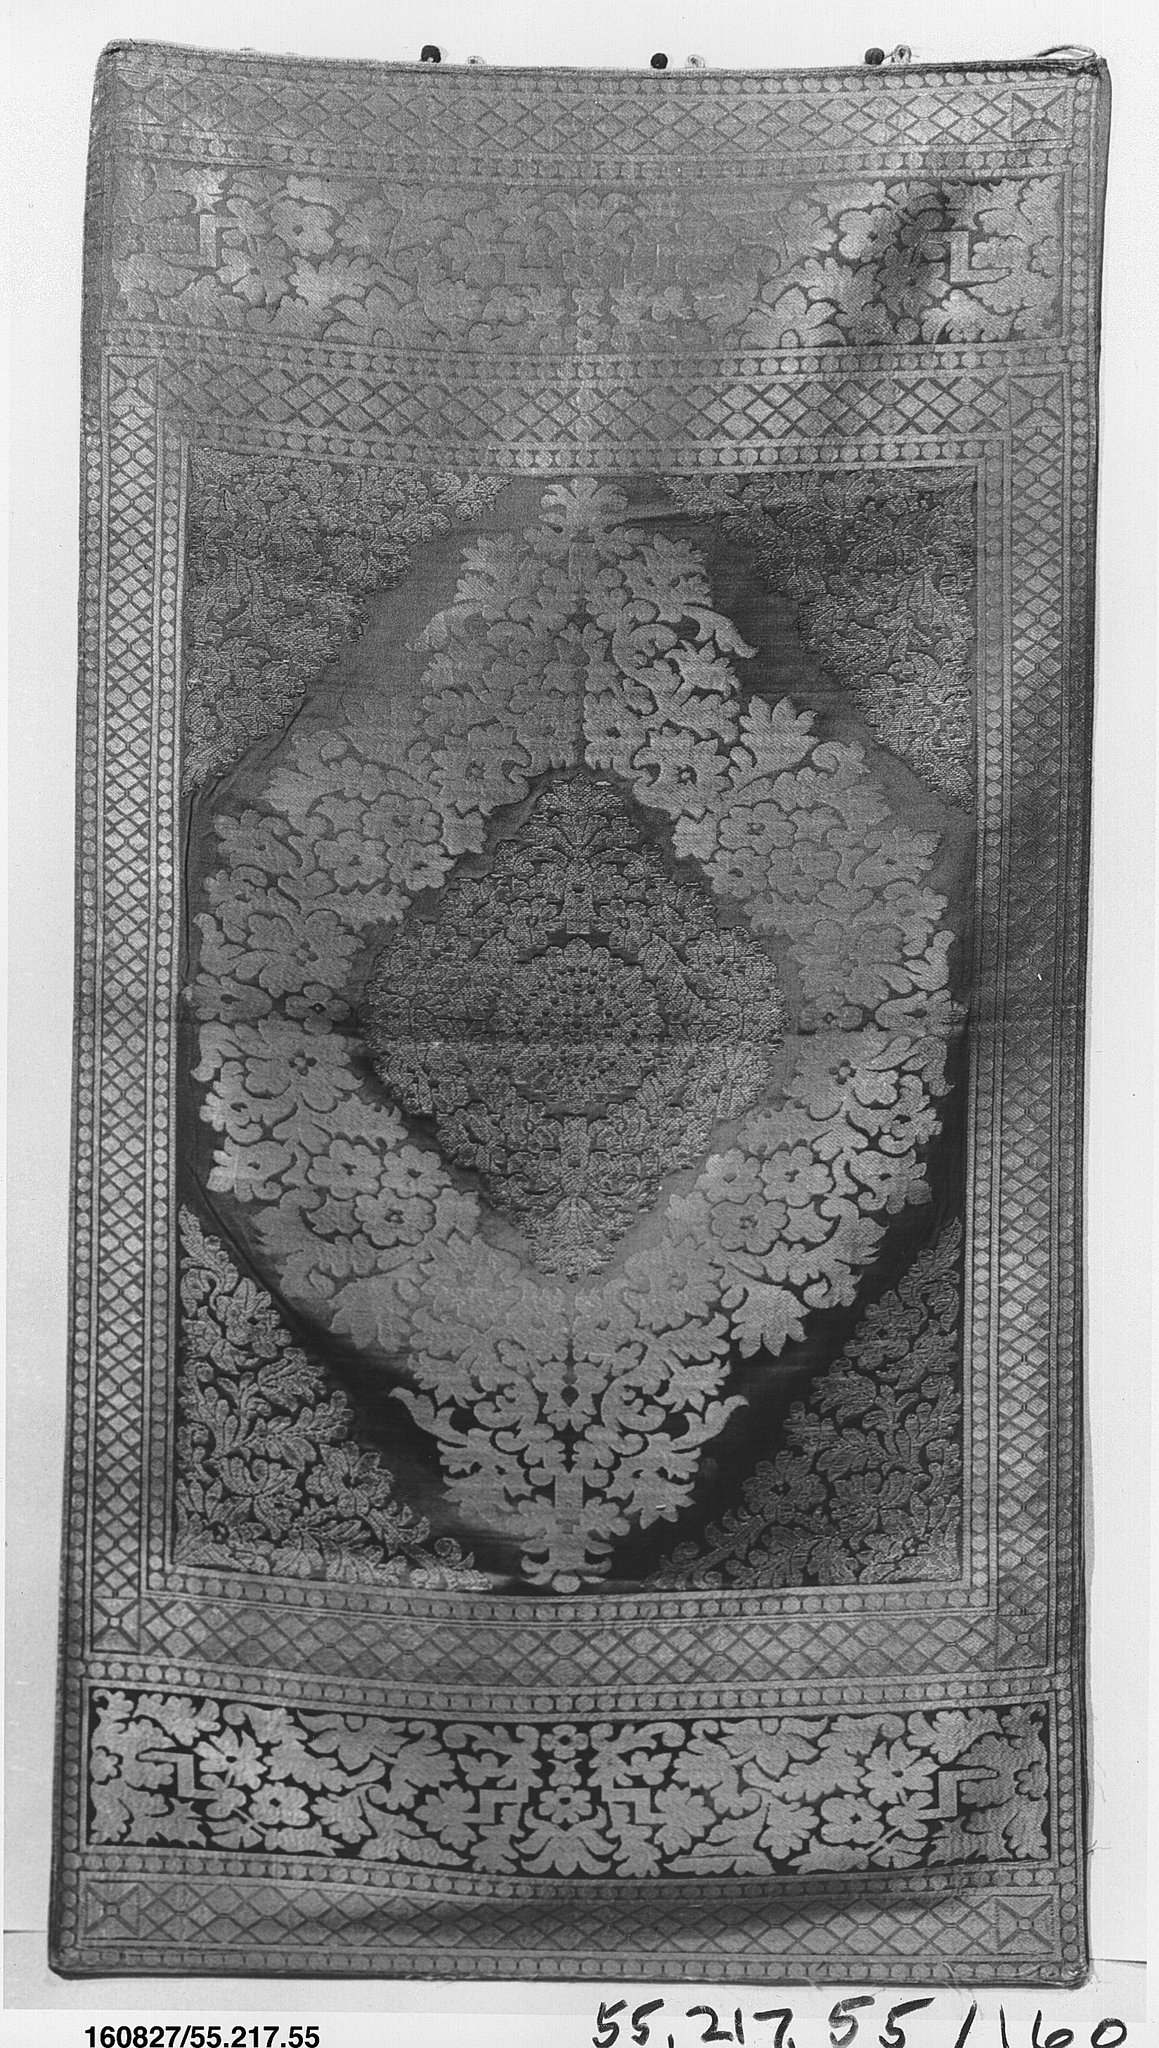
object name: panel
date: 1826-1850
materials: metal thread, silk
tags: flowers